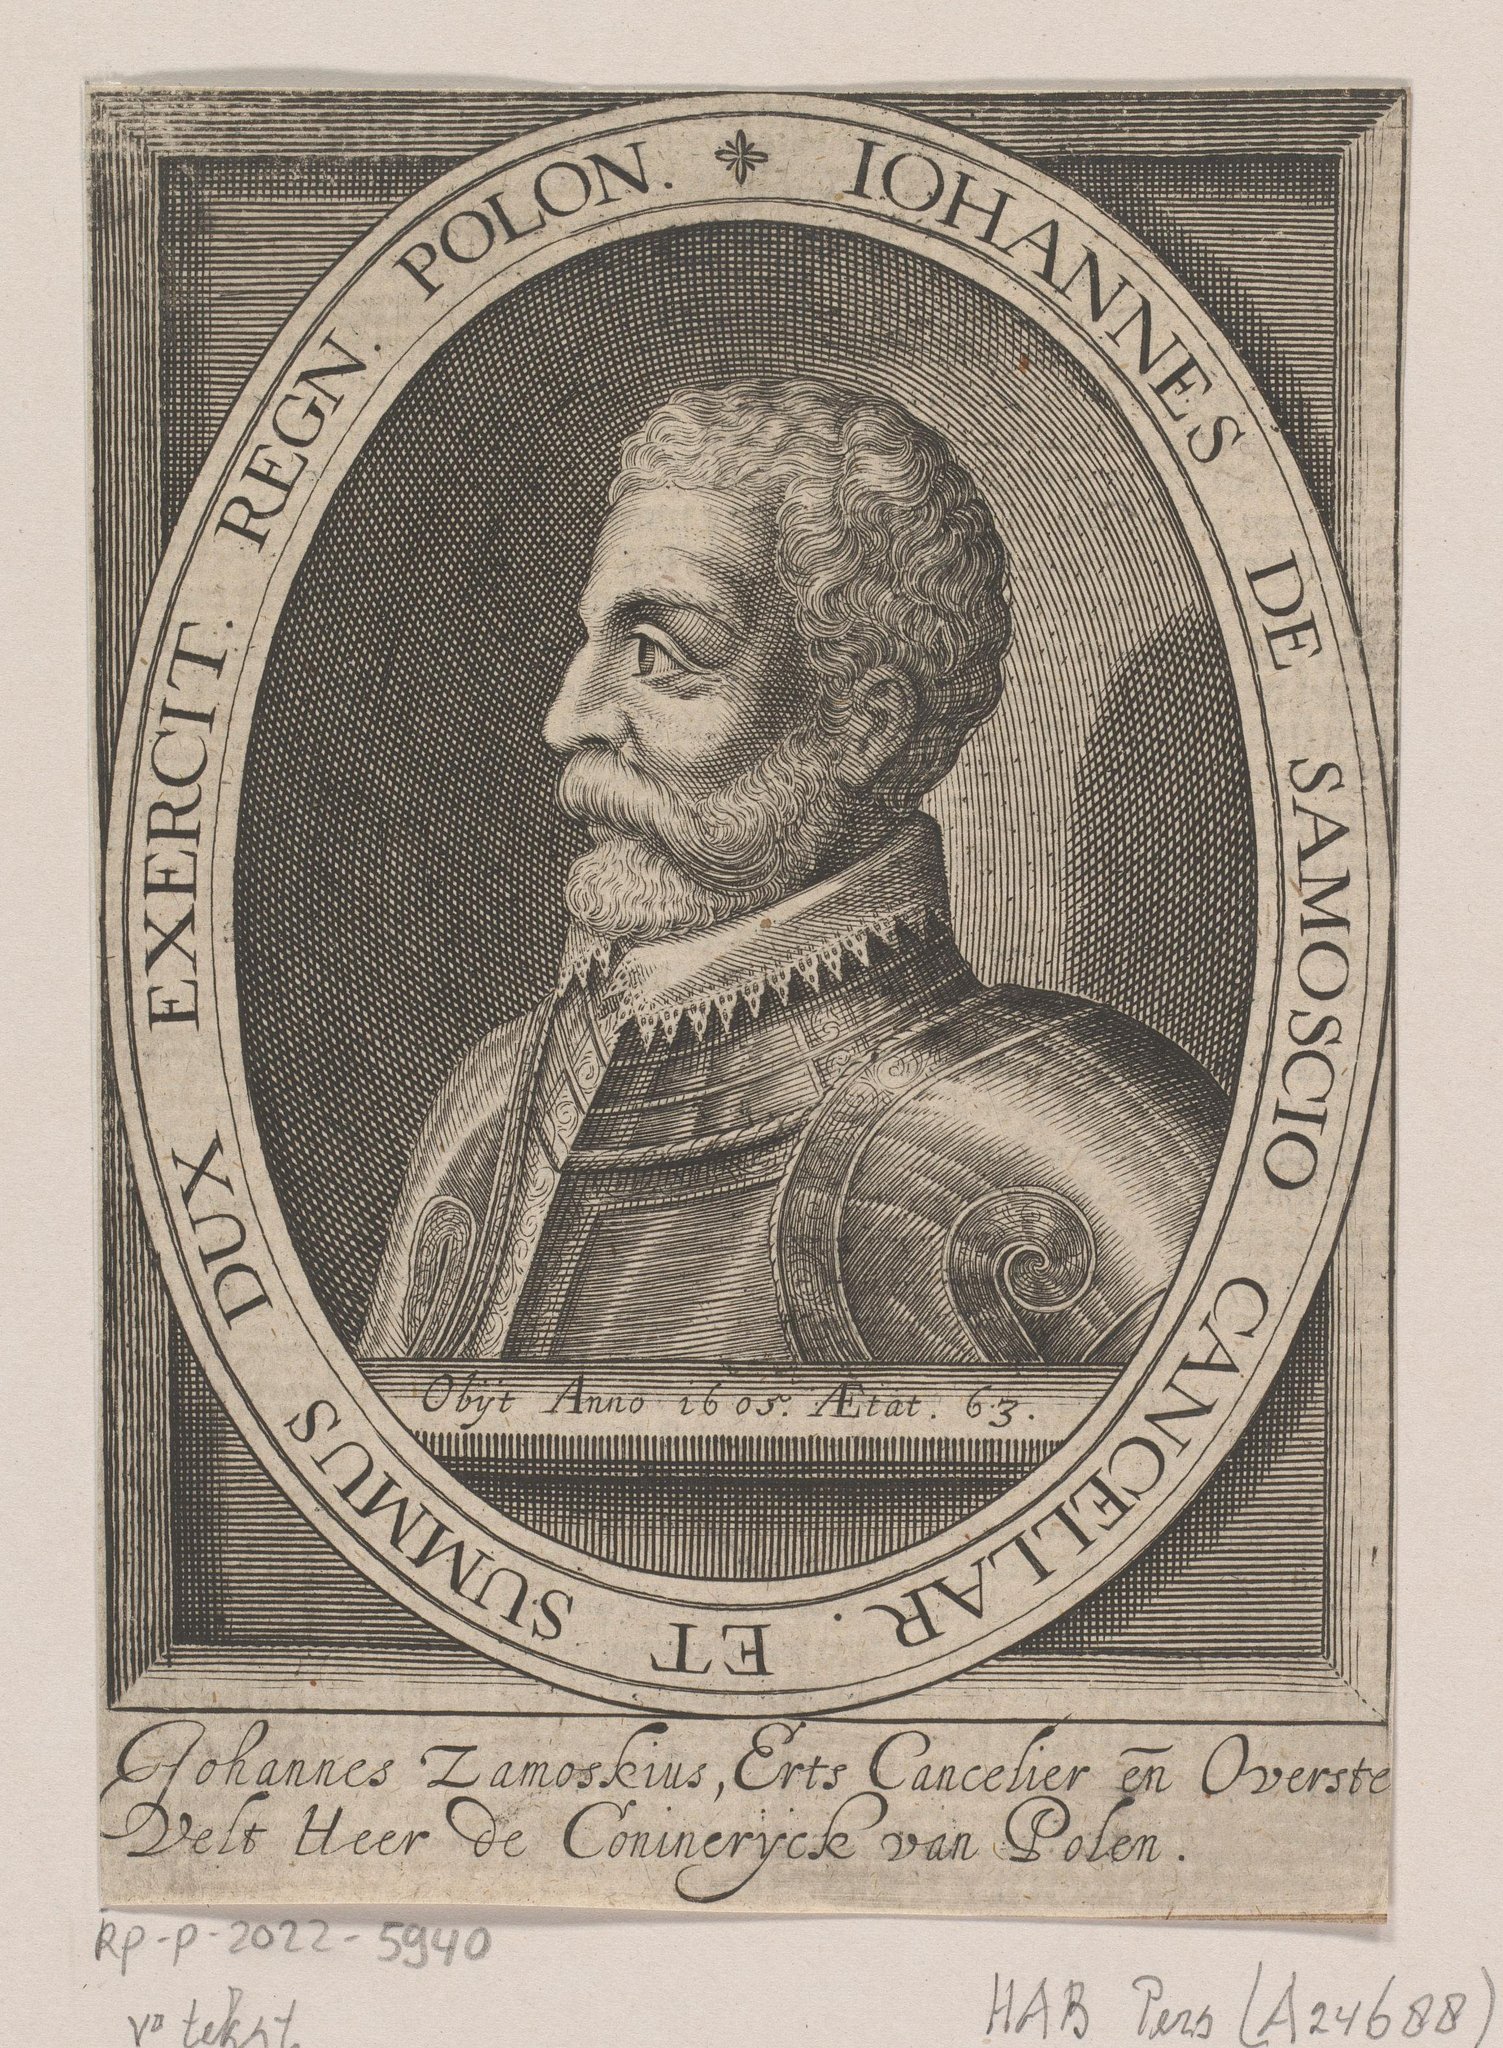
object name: book illustration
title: Portret van Jan Zamoyski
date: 1617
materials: paper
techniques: engraving, letterpress printing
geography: delft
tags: official; civil servant; functionary (in general), historical persons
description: Prent uit: Clerck, Niclaes de. Tooneel der beroemder hertogen princen, (...). Delft: Niclaes de Clerck, 1617, p. 320.